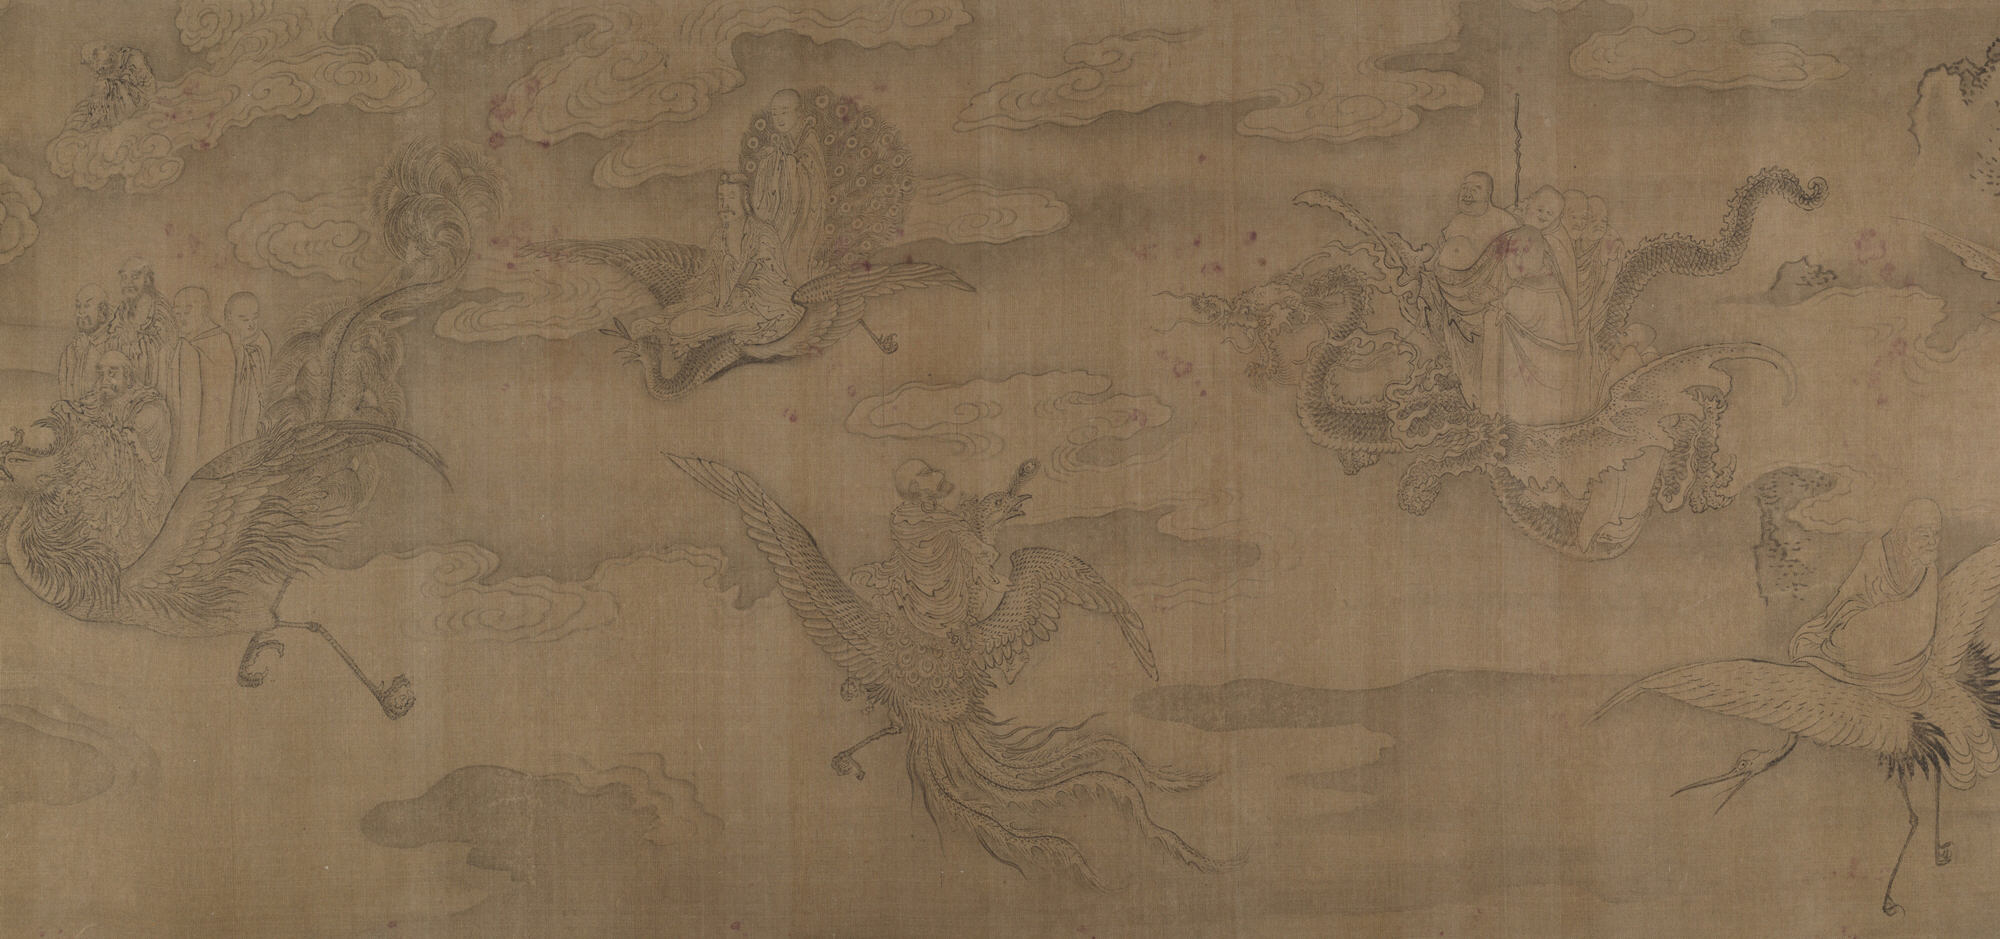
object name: handscroll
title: Holy Men Travelling to the Buddhist Heaven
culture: chinese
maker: unidentified artist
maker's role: artist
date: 1368-1911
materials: ink, silk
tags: birds,men,dragons,buddhism